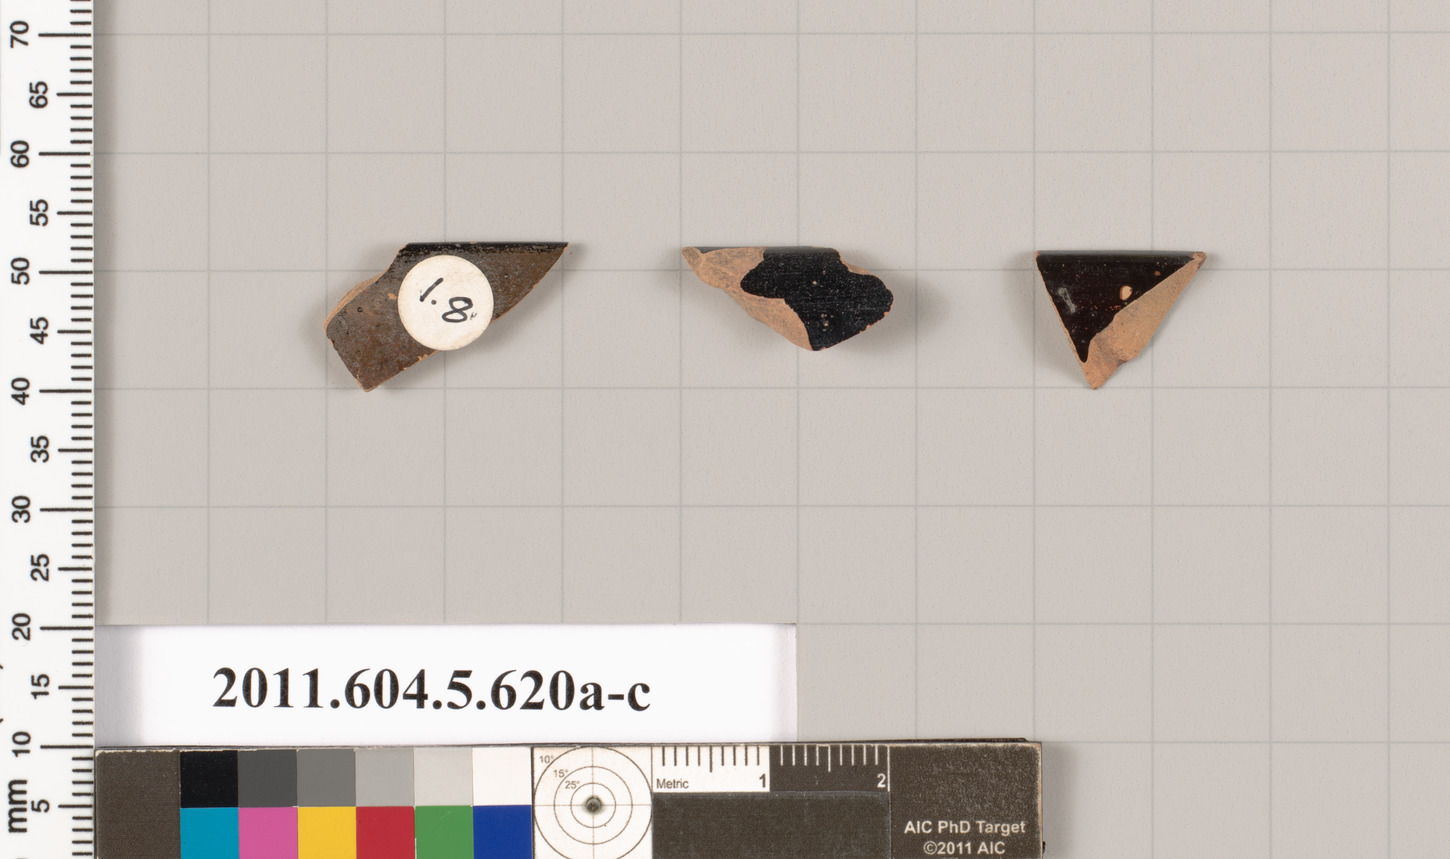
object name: kylix fragment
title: Terracotta rim fragments of kylikes (drinking cups)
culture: greek, attic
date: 600-401 BCE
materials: terracotta